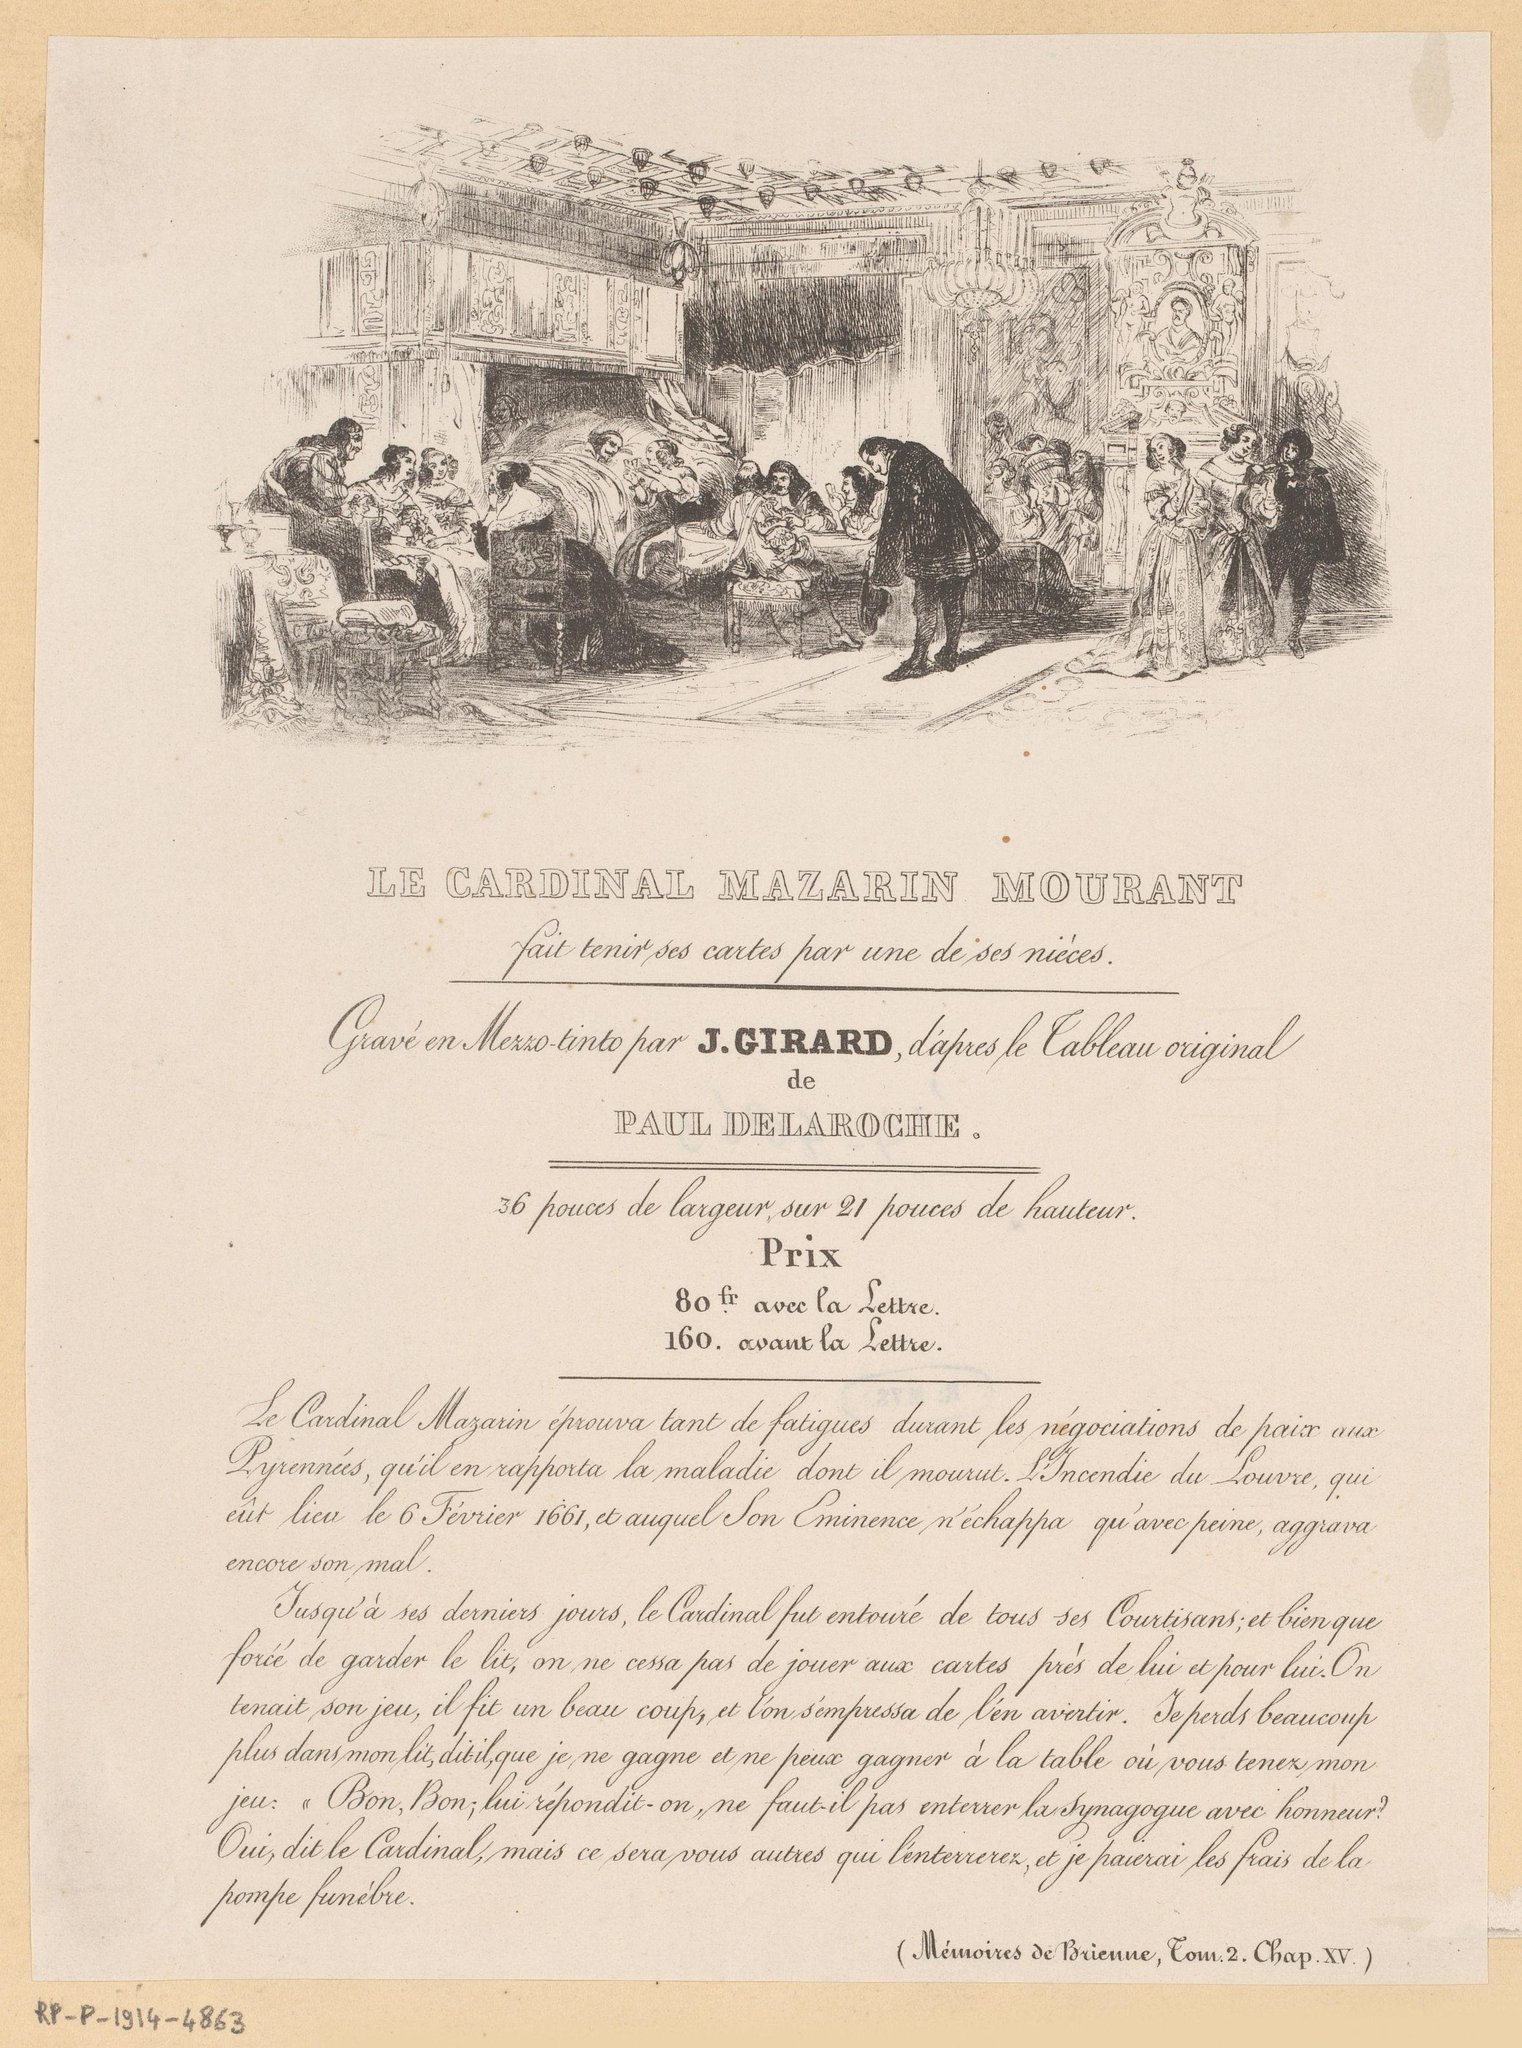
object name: print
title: Kardinaal Jules Mazarin op zijn doodsbed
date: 1807-1899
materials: paper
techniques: etching, roulette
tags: jules mazarin, cardinal, deathbed, historical persons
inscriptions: collector's mark: Lugt 2228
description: Mogelijk betreft dit een reclameprent voor een editie van de Mémoires de Louis-Henri de Lomenie, comte de Brienne (...), met een afbeelding en tekst uit deel 2, hoofdstuk 15.